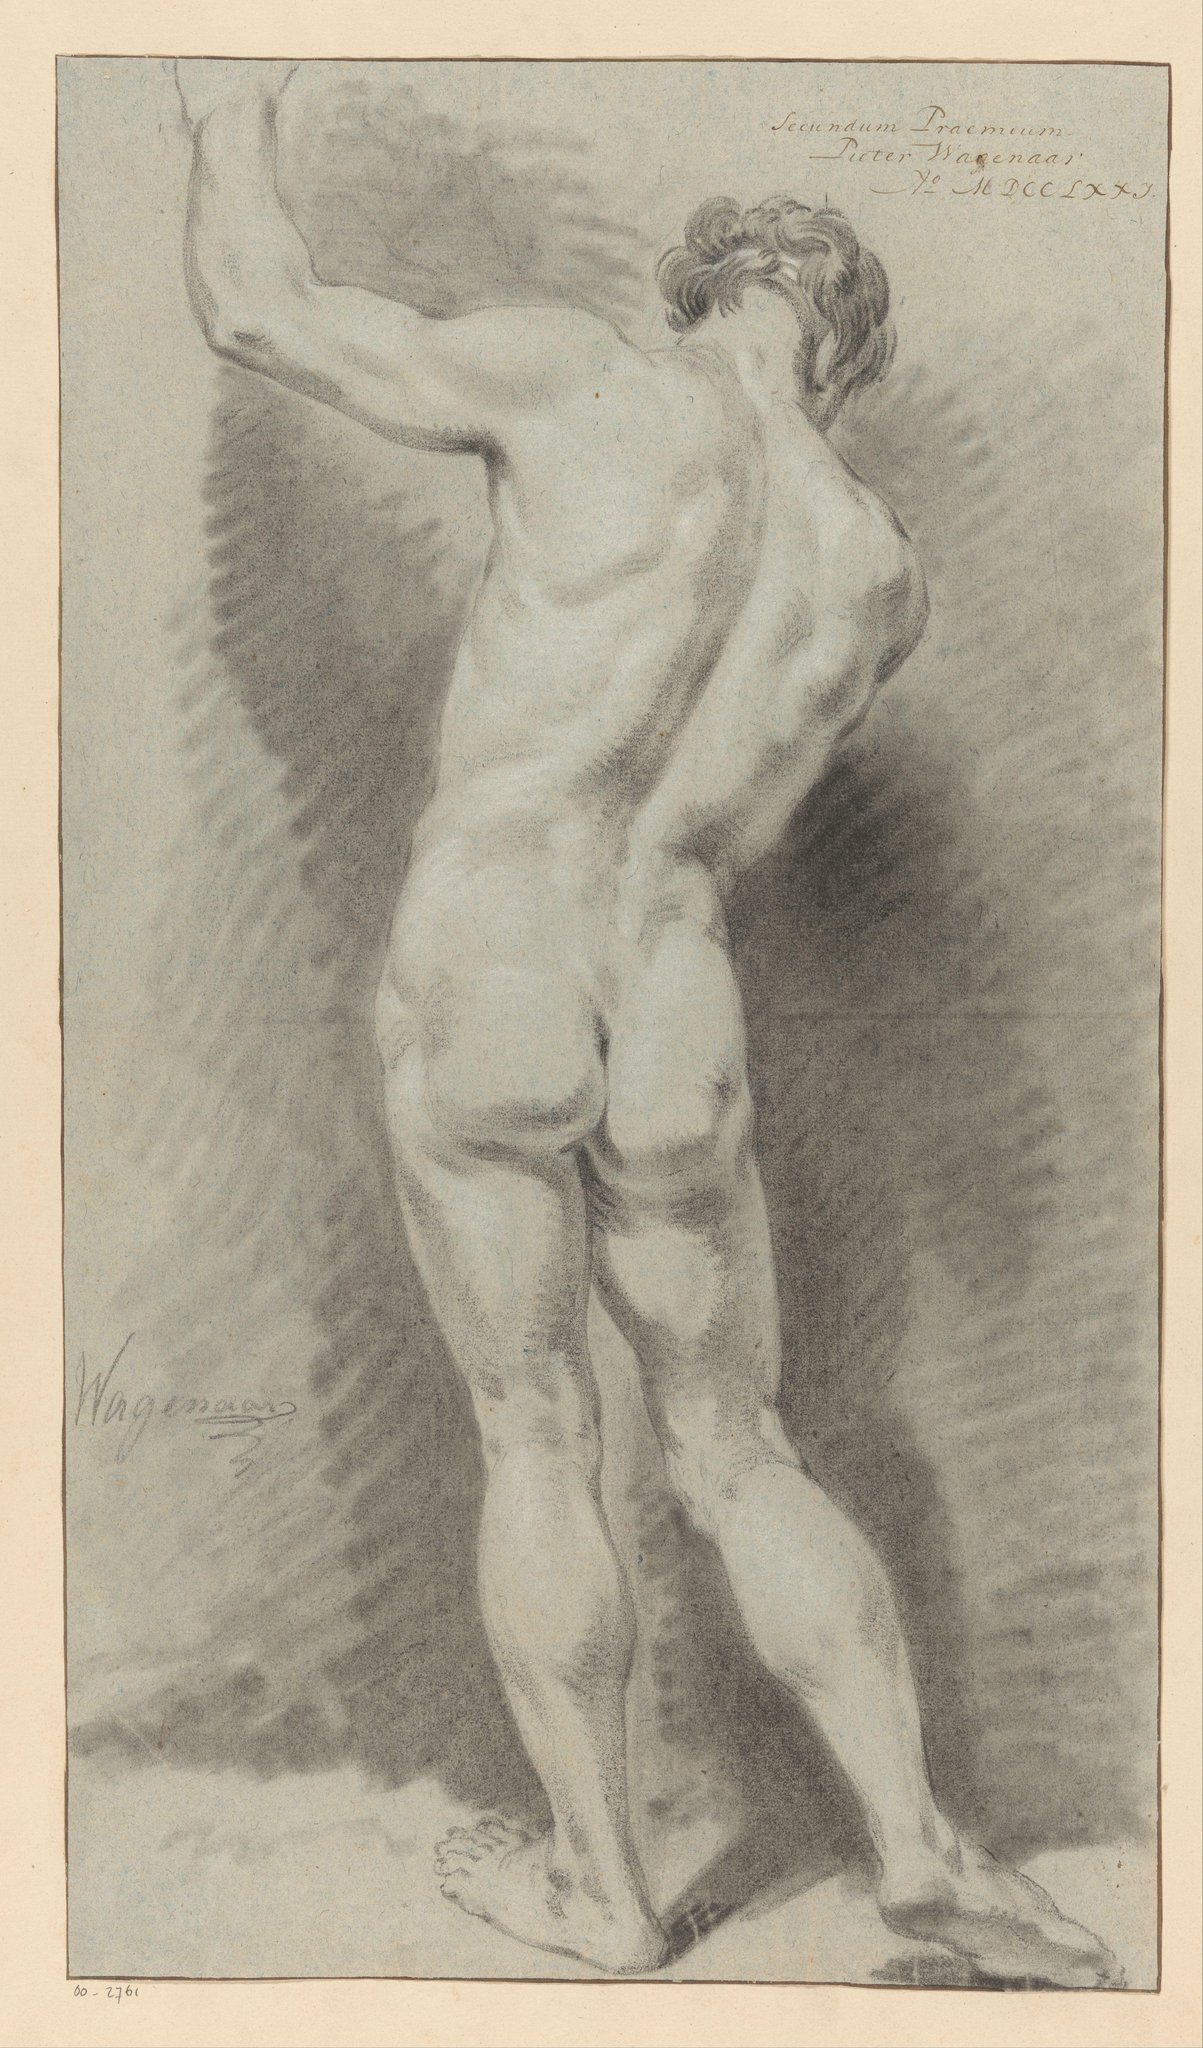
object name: drawing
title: Staand mannelijk naakt, op de rug gezien (2e prijs 1771)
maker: pieter wagenaar (ii)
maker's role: draughtsman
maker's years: 1747-1808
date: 1771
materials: chalk, paper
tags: standing figure (+ nude human being)